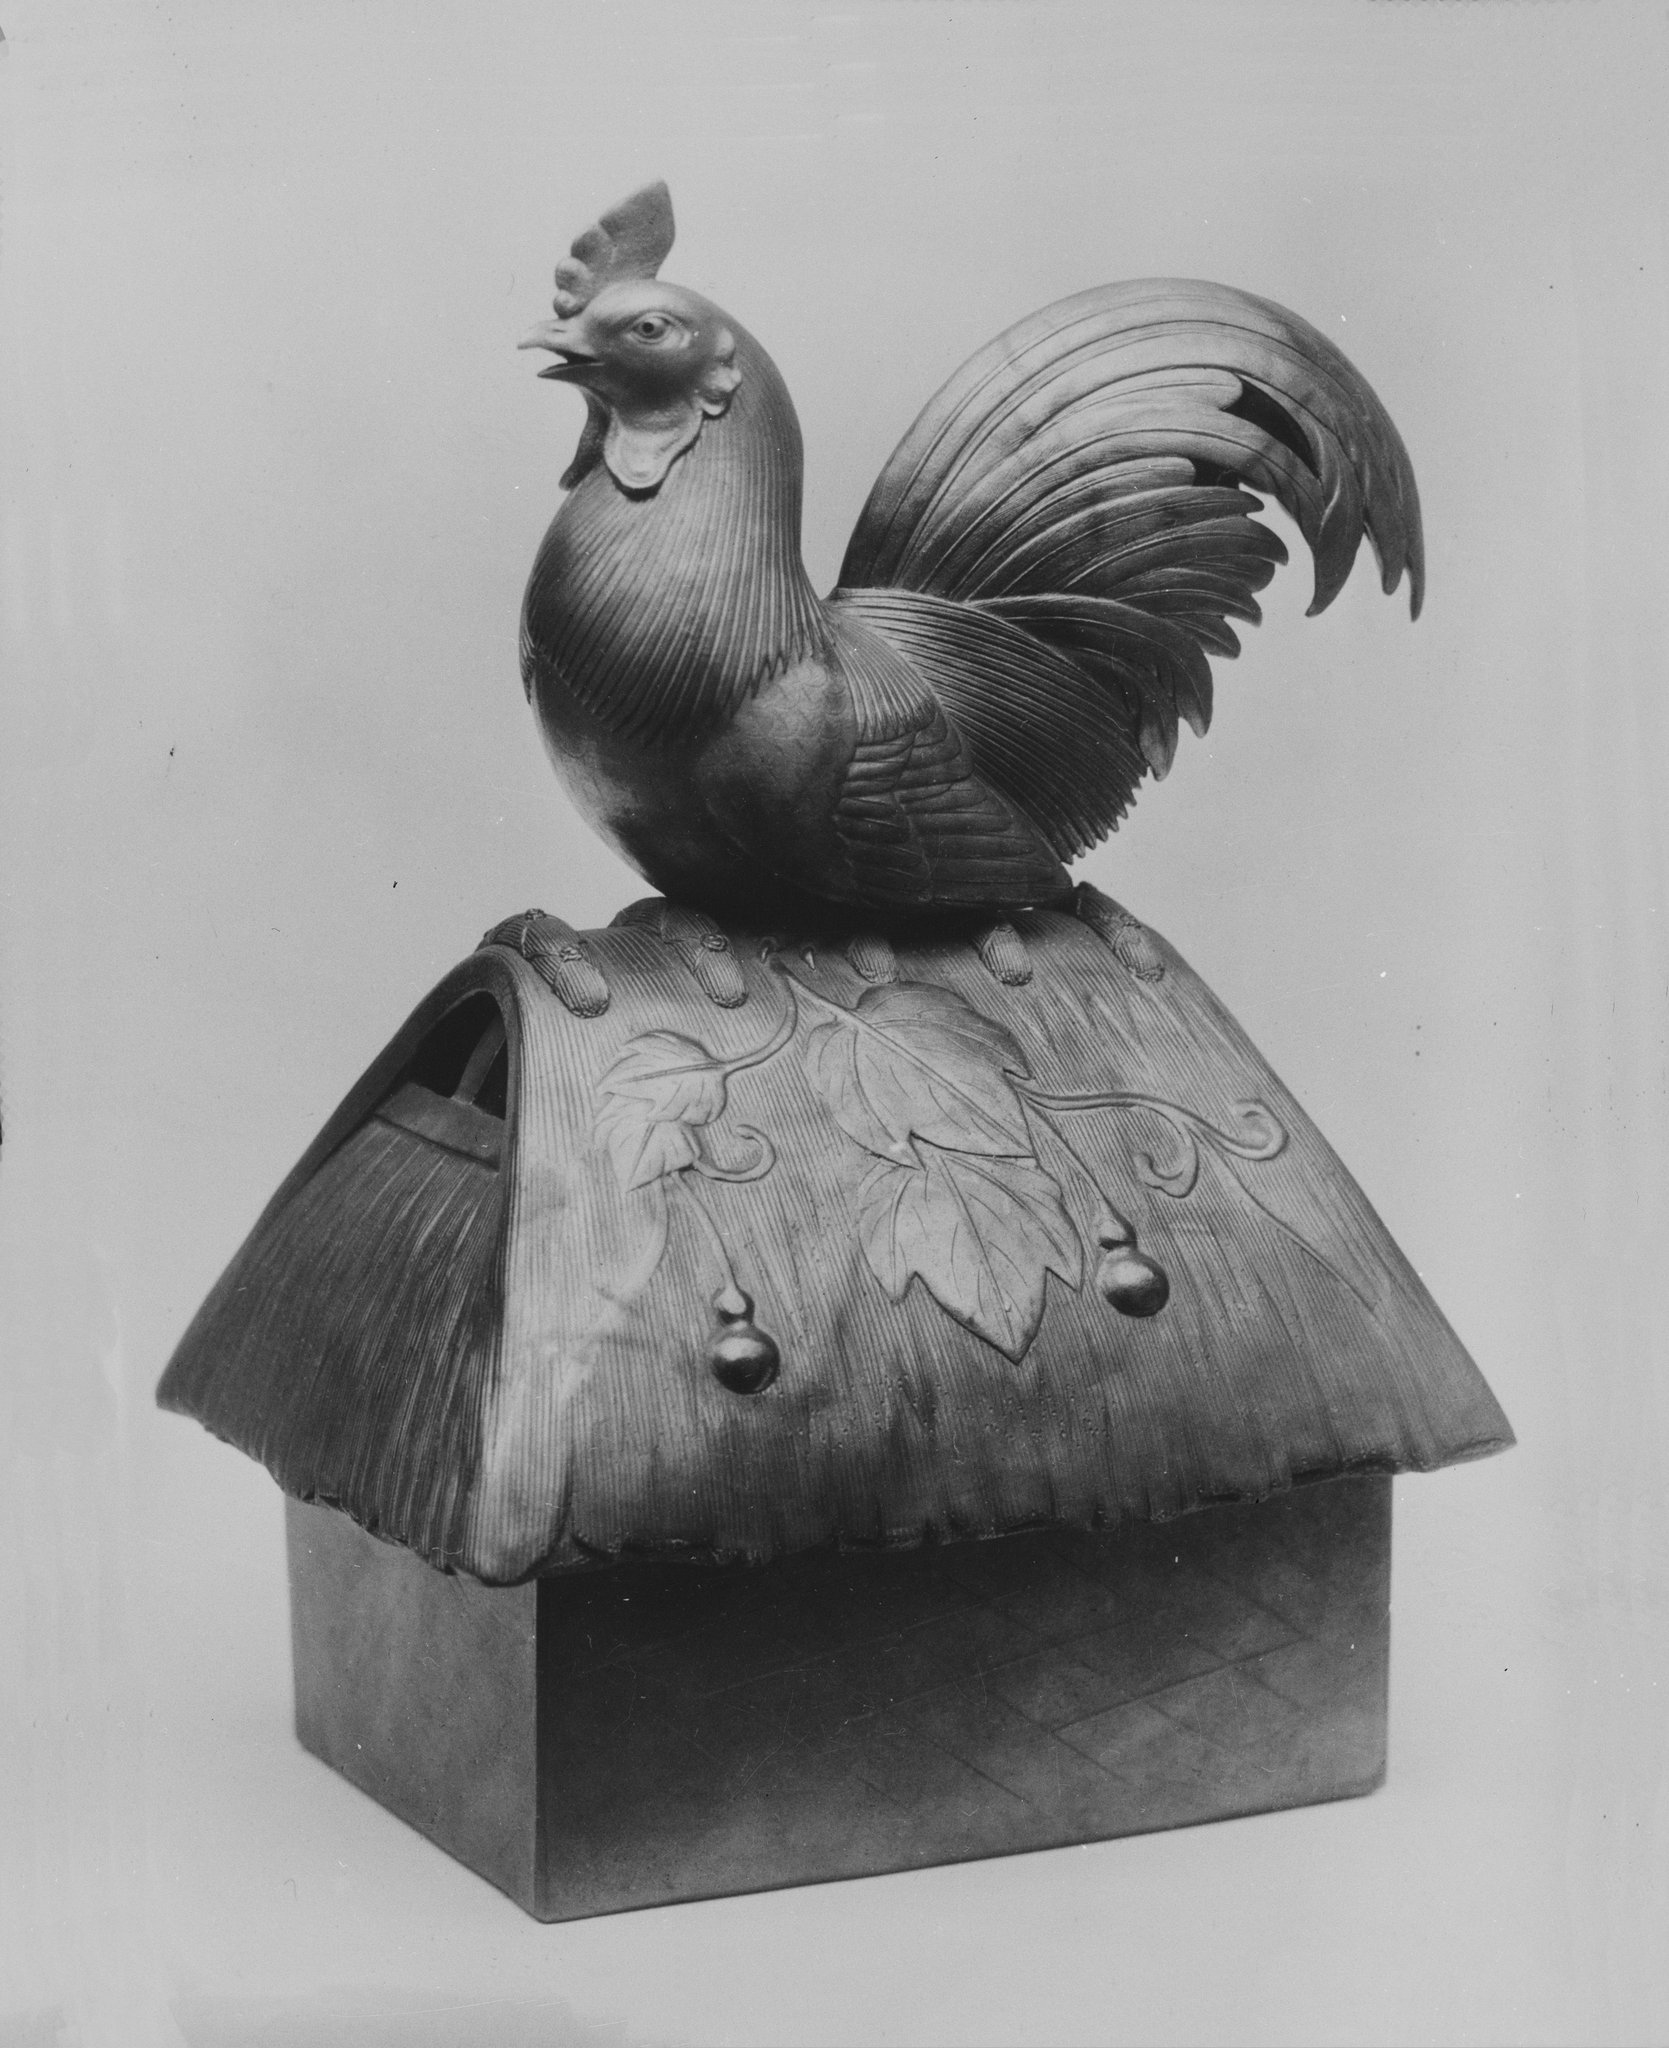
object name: censer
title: Censer in Form of a Rooster Perched on a Rooftop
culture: japanese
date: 1700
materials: glaze, stoneware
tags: houses,roofs,roosters,leaves,censers